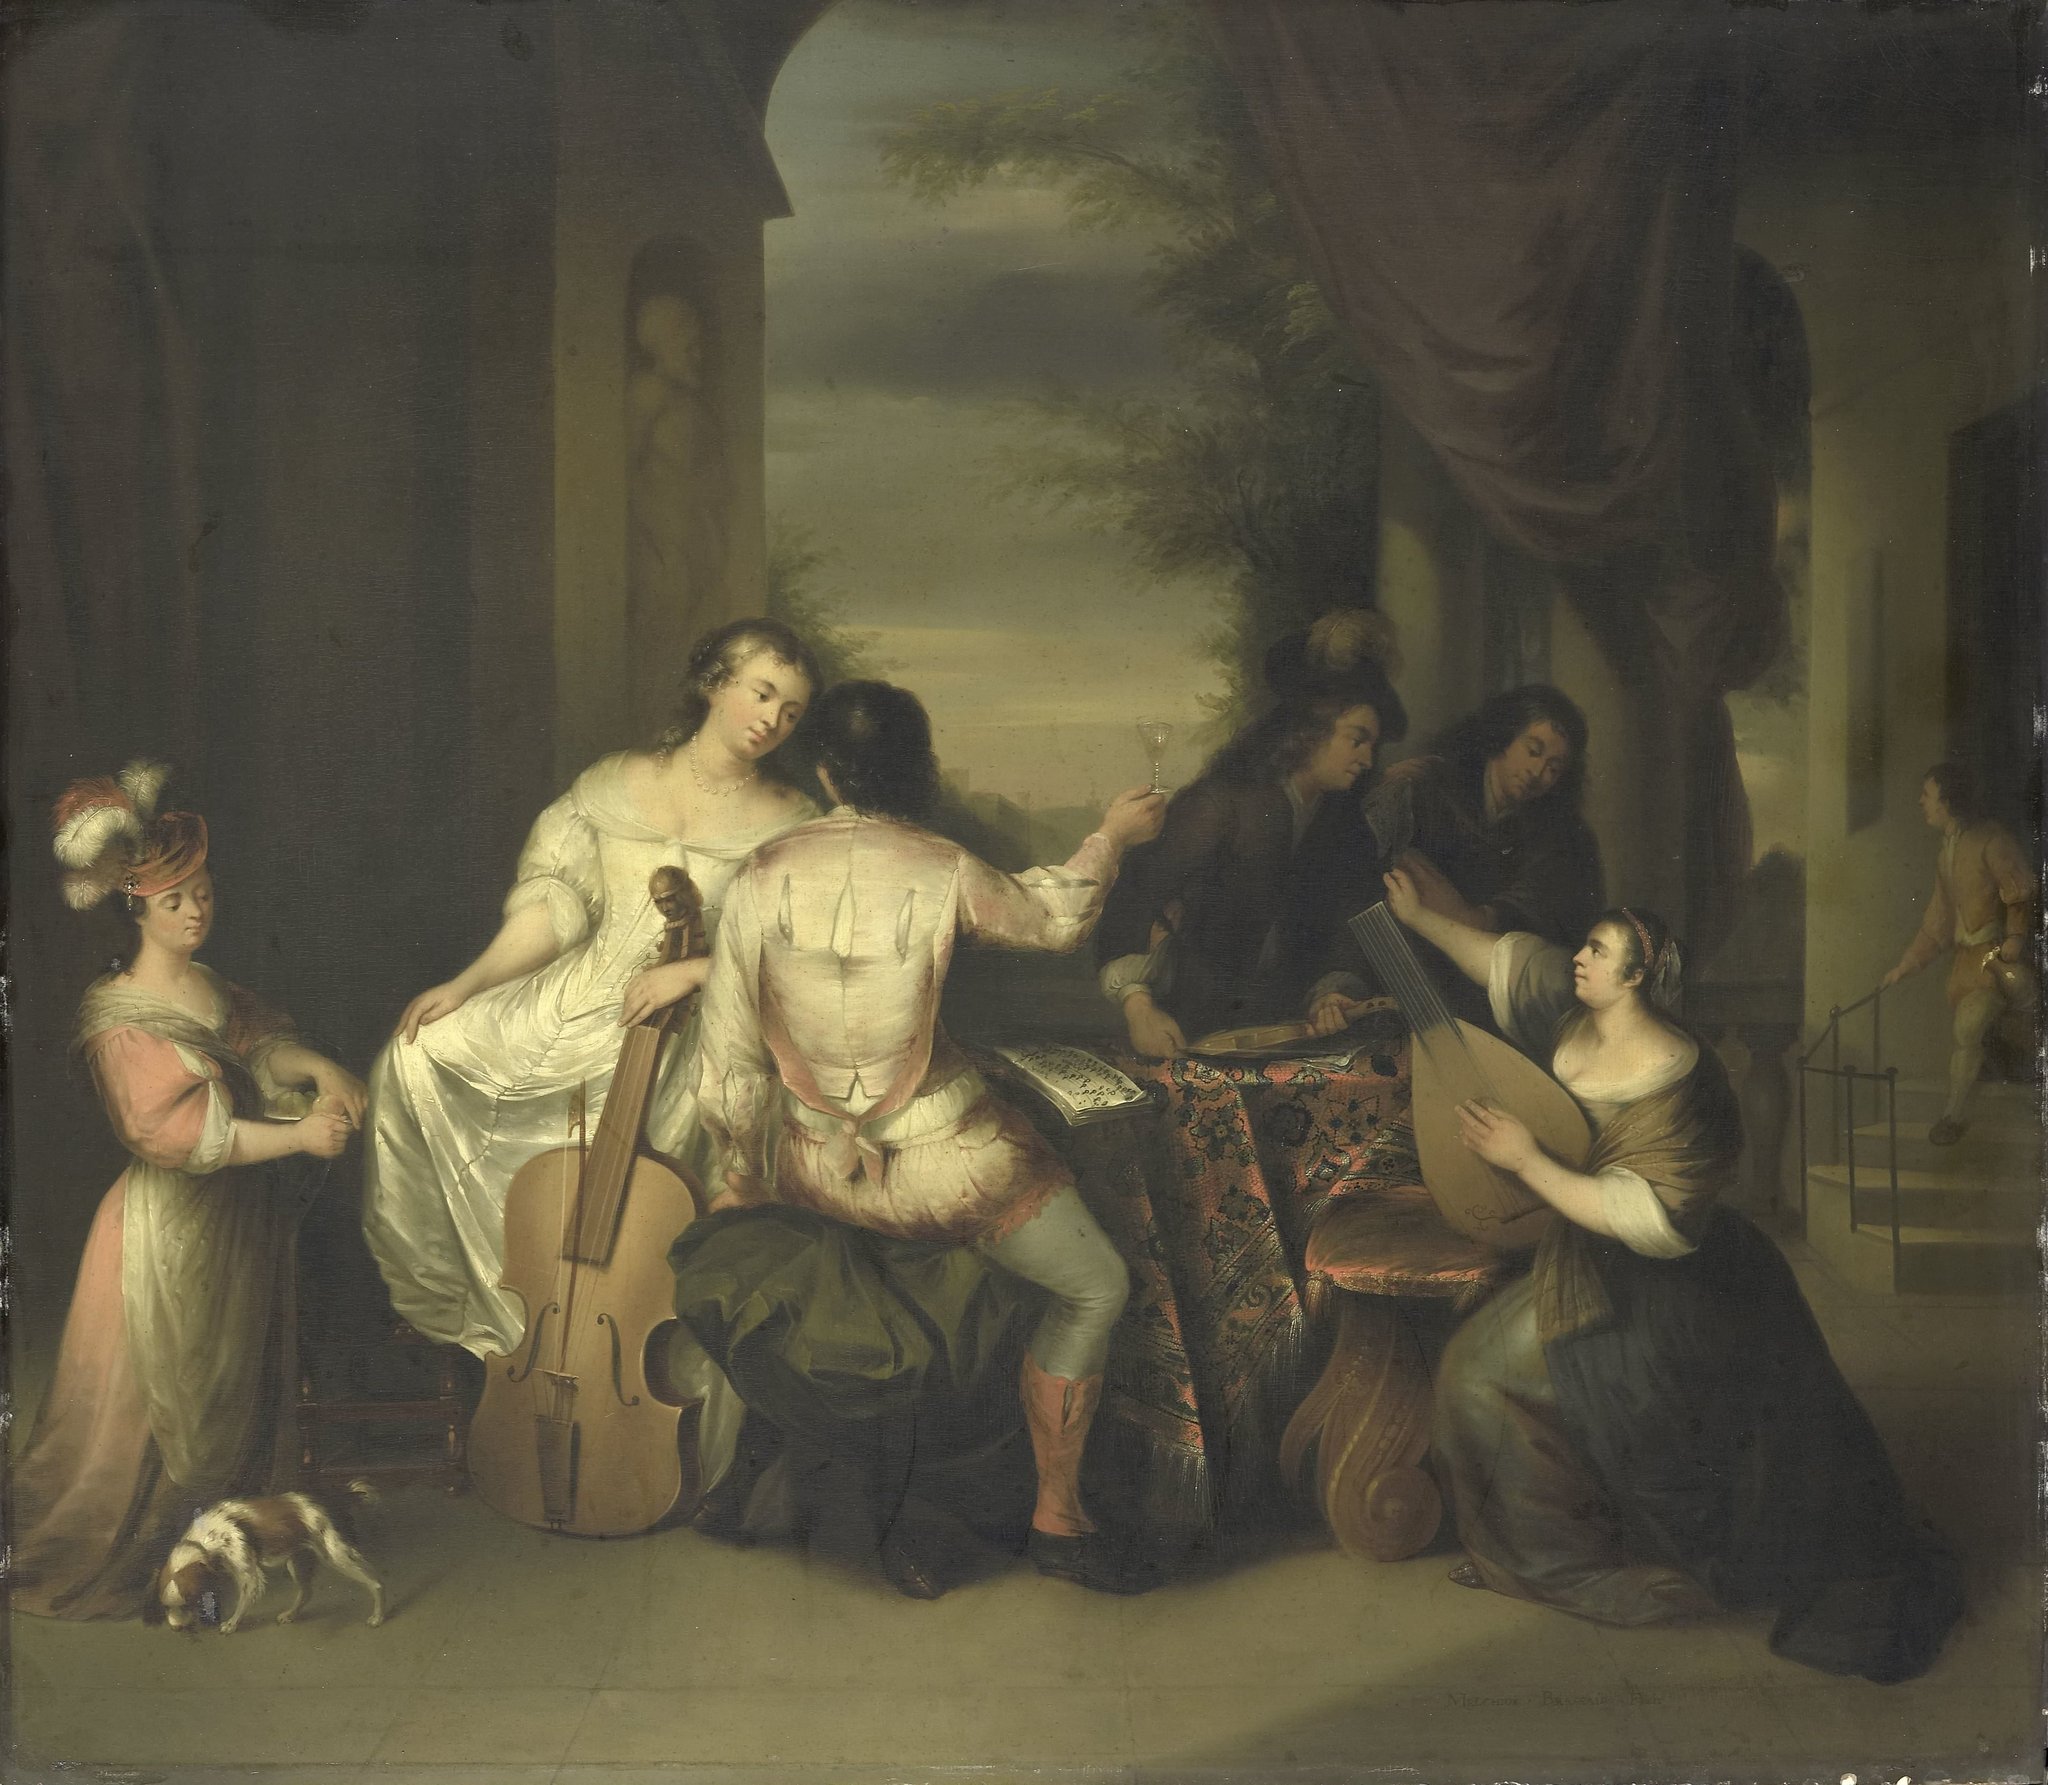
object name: painting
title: A Musical Company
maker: melchior brassauw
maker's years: 1709-1757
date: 1730-1757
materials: oil, panel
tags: private festivities, merry company - aa - in the open air, 'fête champêtre', small group of musicians, chamber orchestra, jazz band - cc - 'concert champêtre'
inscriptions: signature: ‘Melchior Brassauw: Fecit.’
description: Musicerend gezelschap op een terras. Rechts een vrouw die een luit stemt, achter de tafel een man met een viool, links een vrouw met een cello bij een zittende man die een glas heft. Op tafel ligt bladmuziek. Vroeger ook wel beschouwd als de Verloren Zoon.